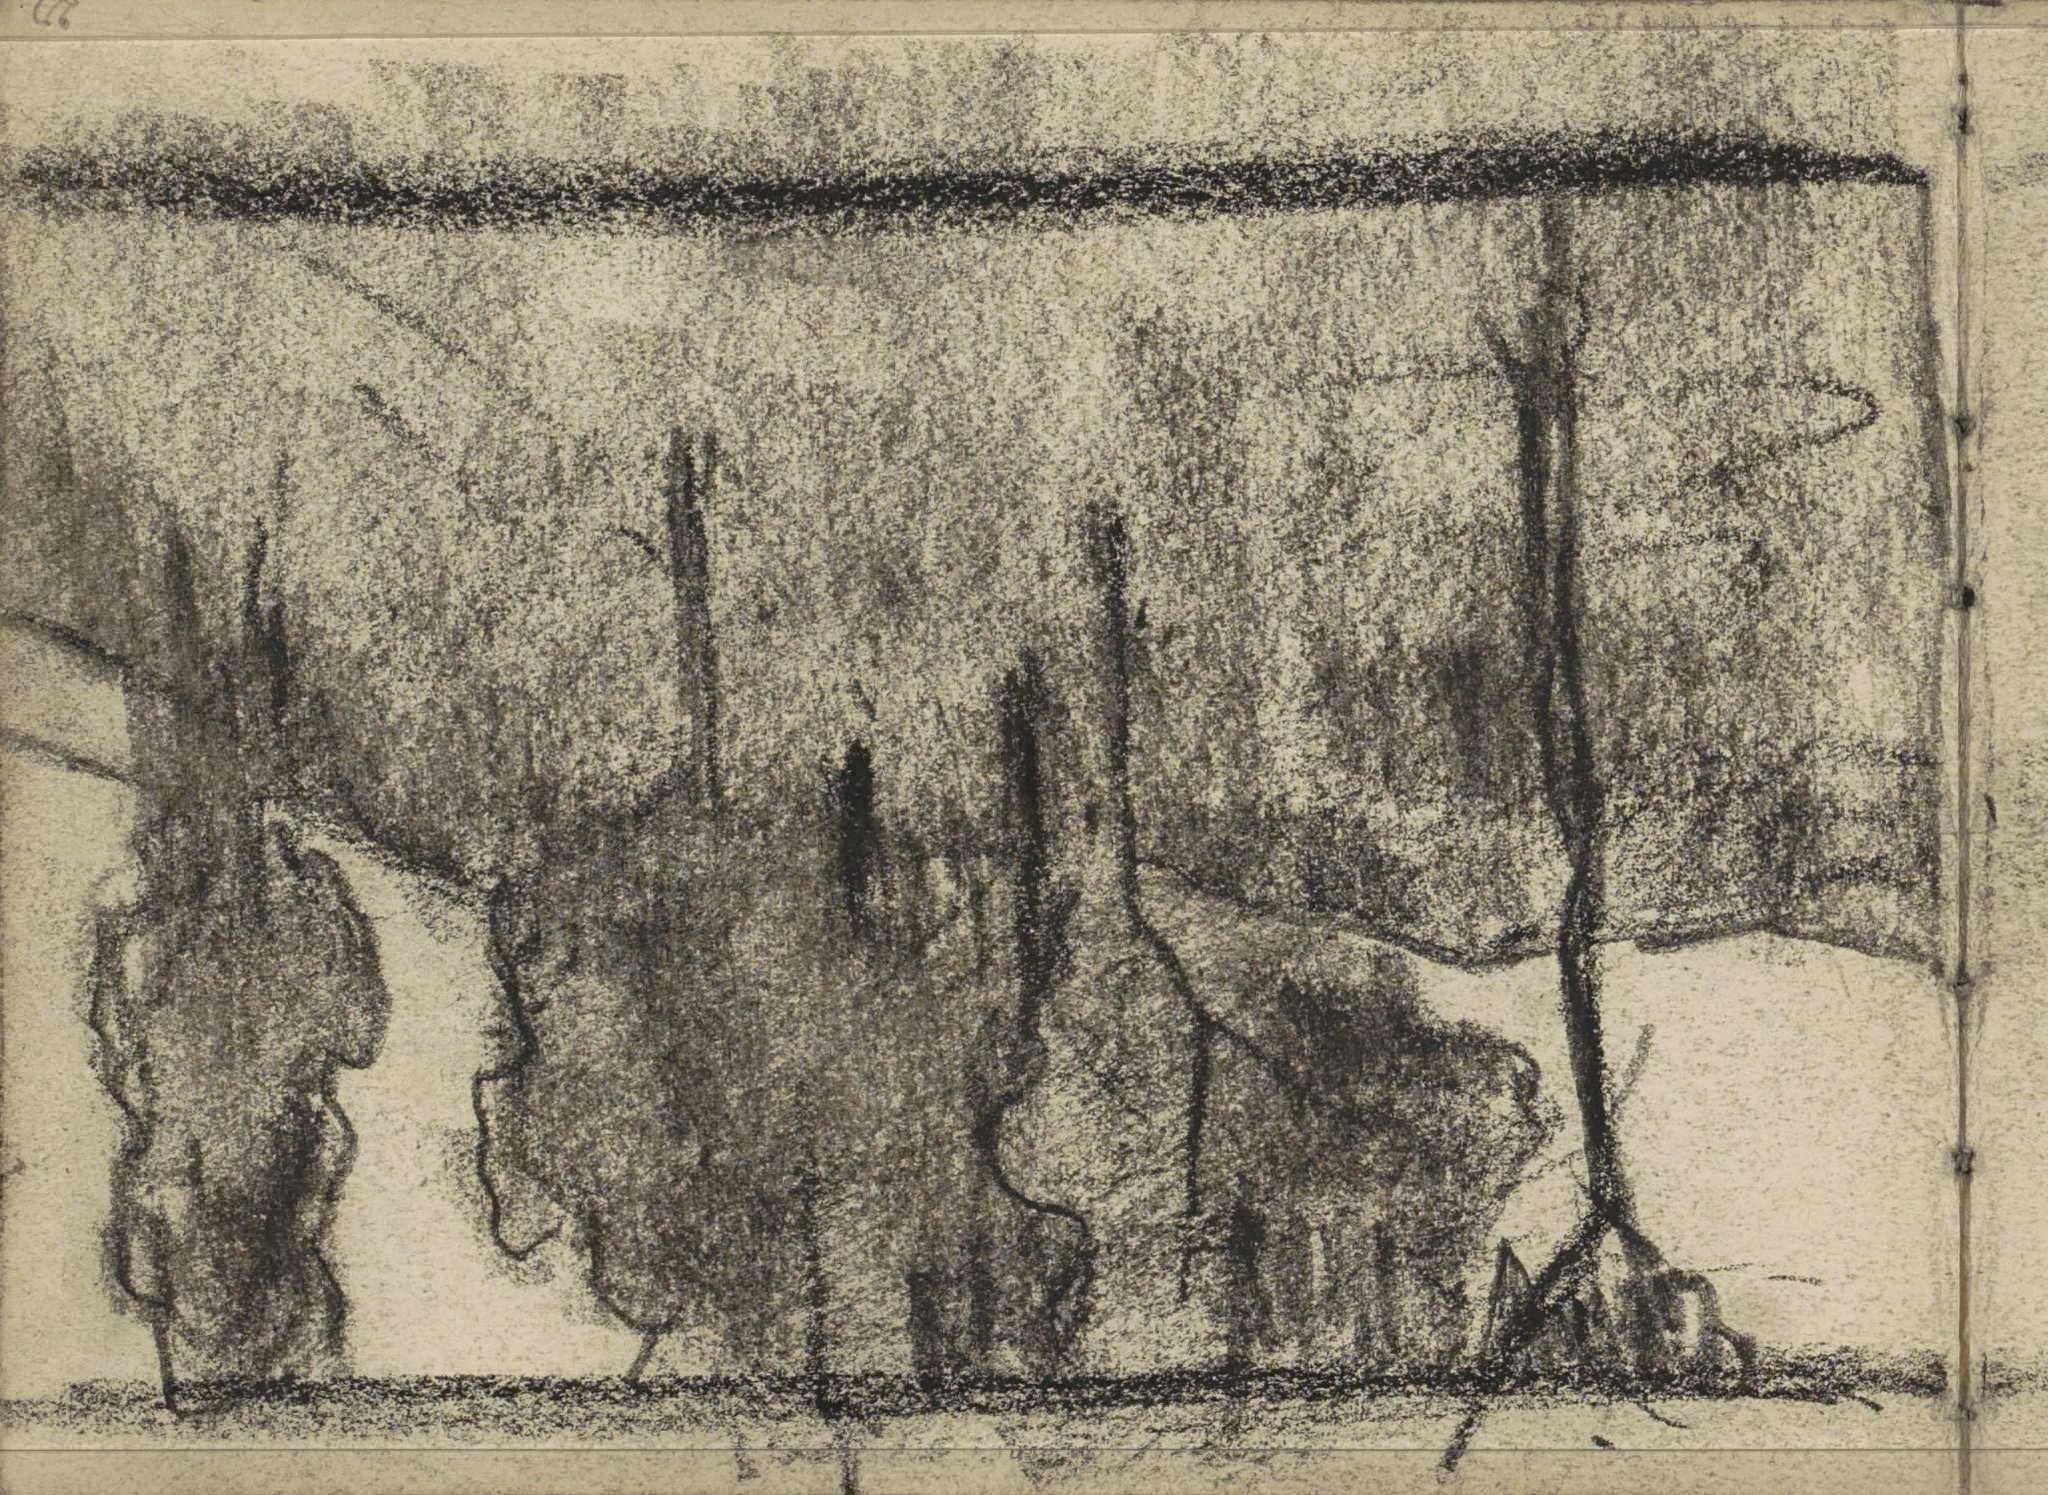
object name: sketchbook leaf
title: Bomen op een heuvel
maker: hermannus adrianus van oosterzee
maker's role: draughtsman, painter, print maker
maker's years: 1863-1933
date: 1893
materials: charcoal, paper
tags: trees, mound, verge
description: Tekening in een kader. Blad 20 verso uit een schetsboek met 23 bladen.